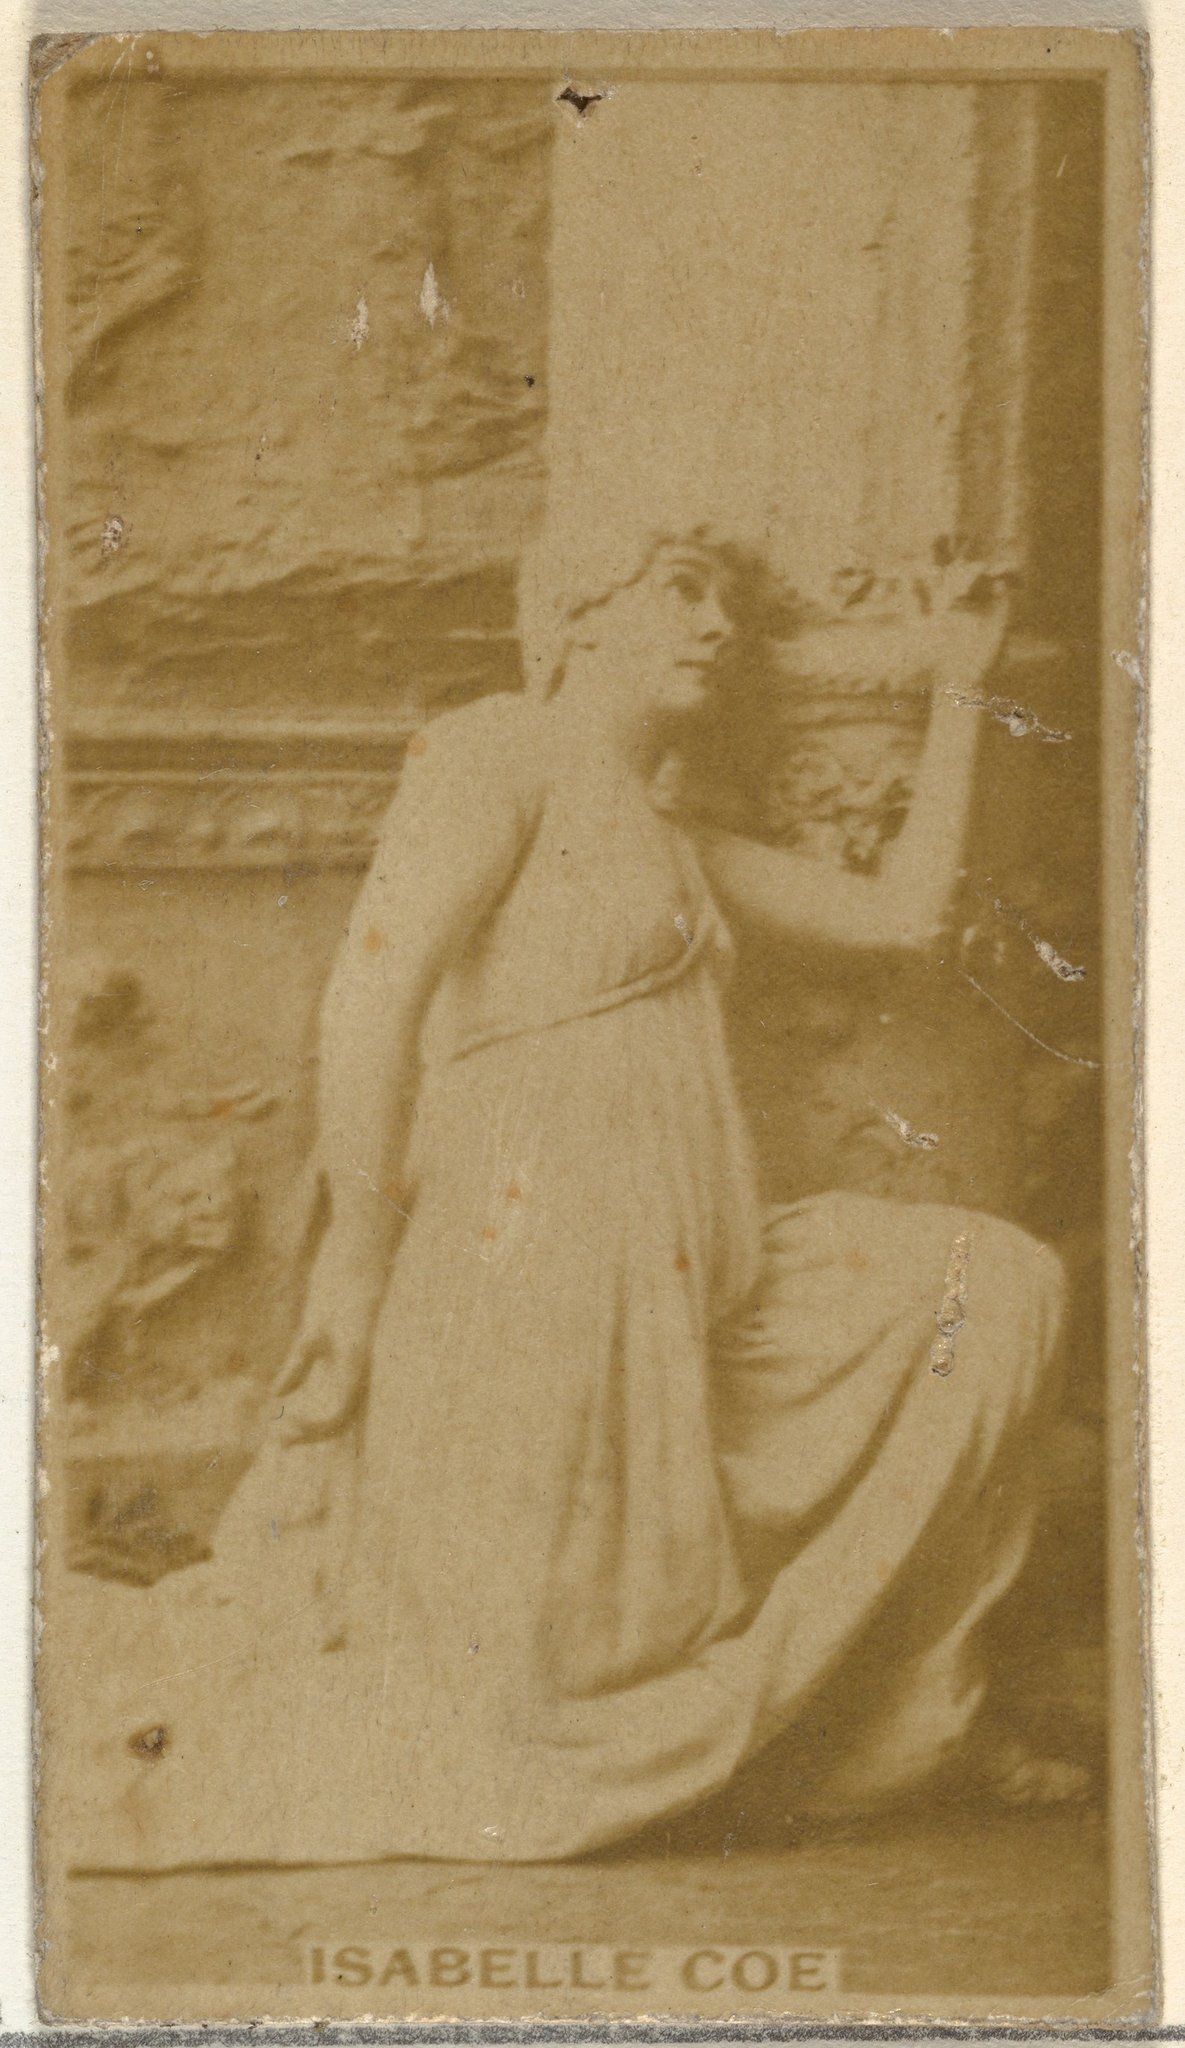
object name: photograph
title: Isabelle Coe, from the Actors and Actresses series (N145-8) issued by Duke Sons & Co. to promote Duke Cigarettes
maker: w. duke, sons & co.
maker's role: publisher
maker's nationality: american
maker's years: 1870-1920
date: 1891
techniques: albumen silver print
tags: portraits,women,actresses